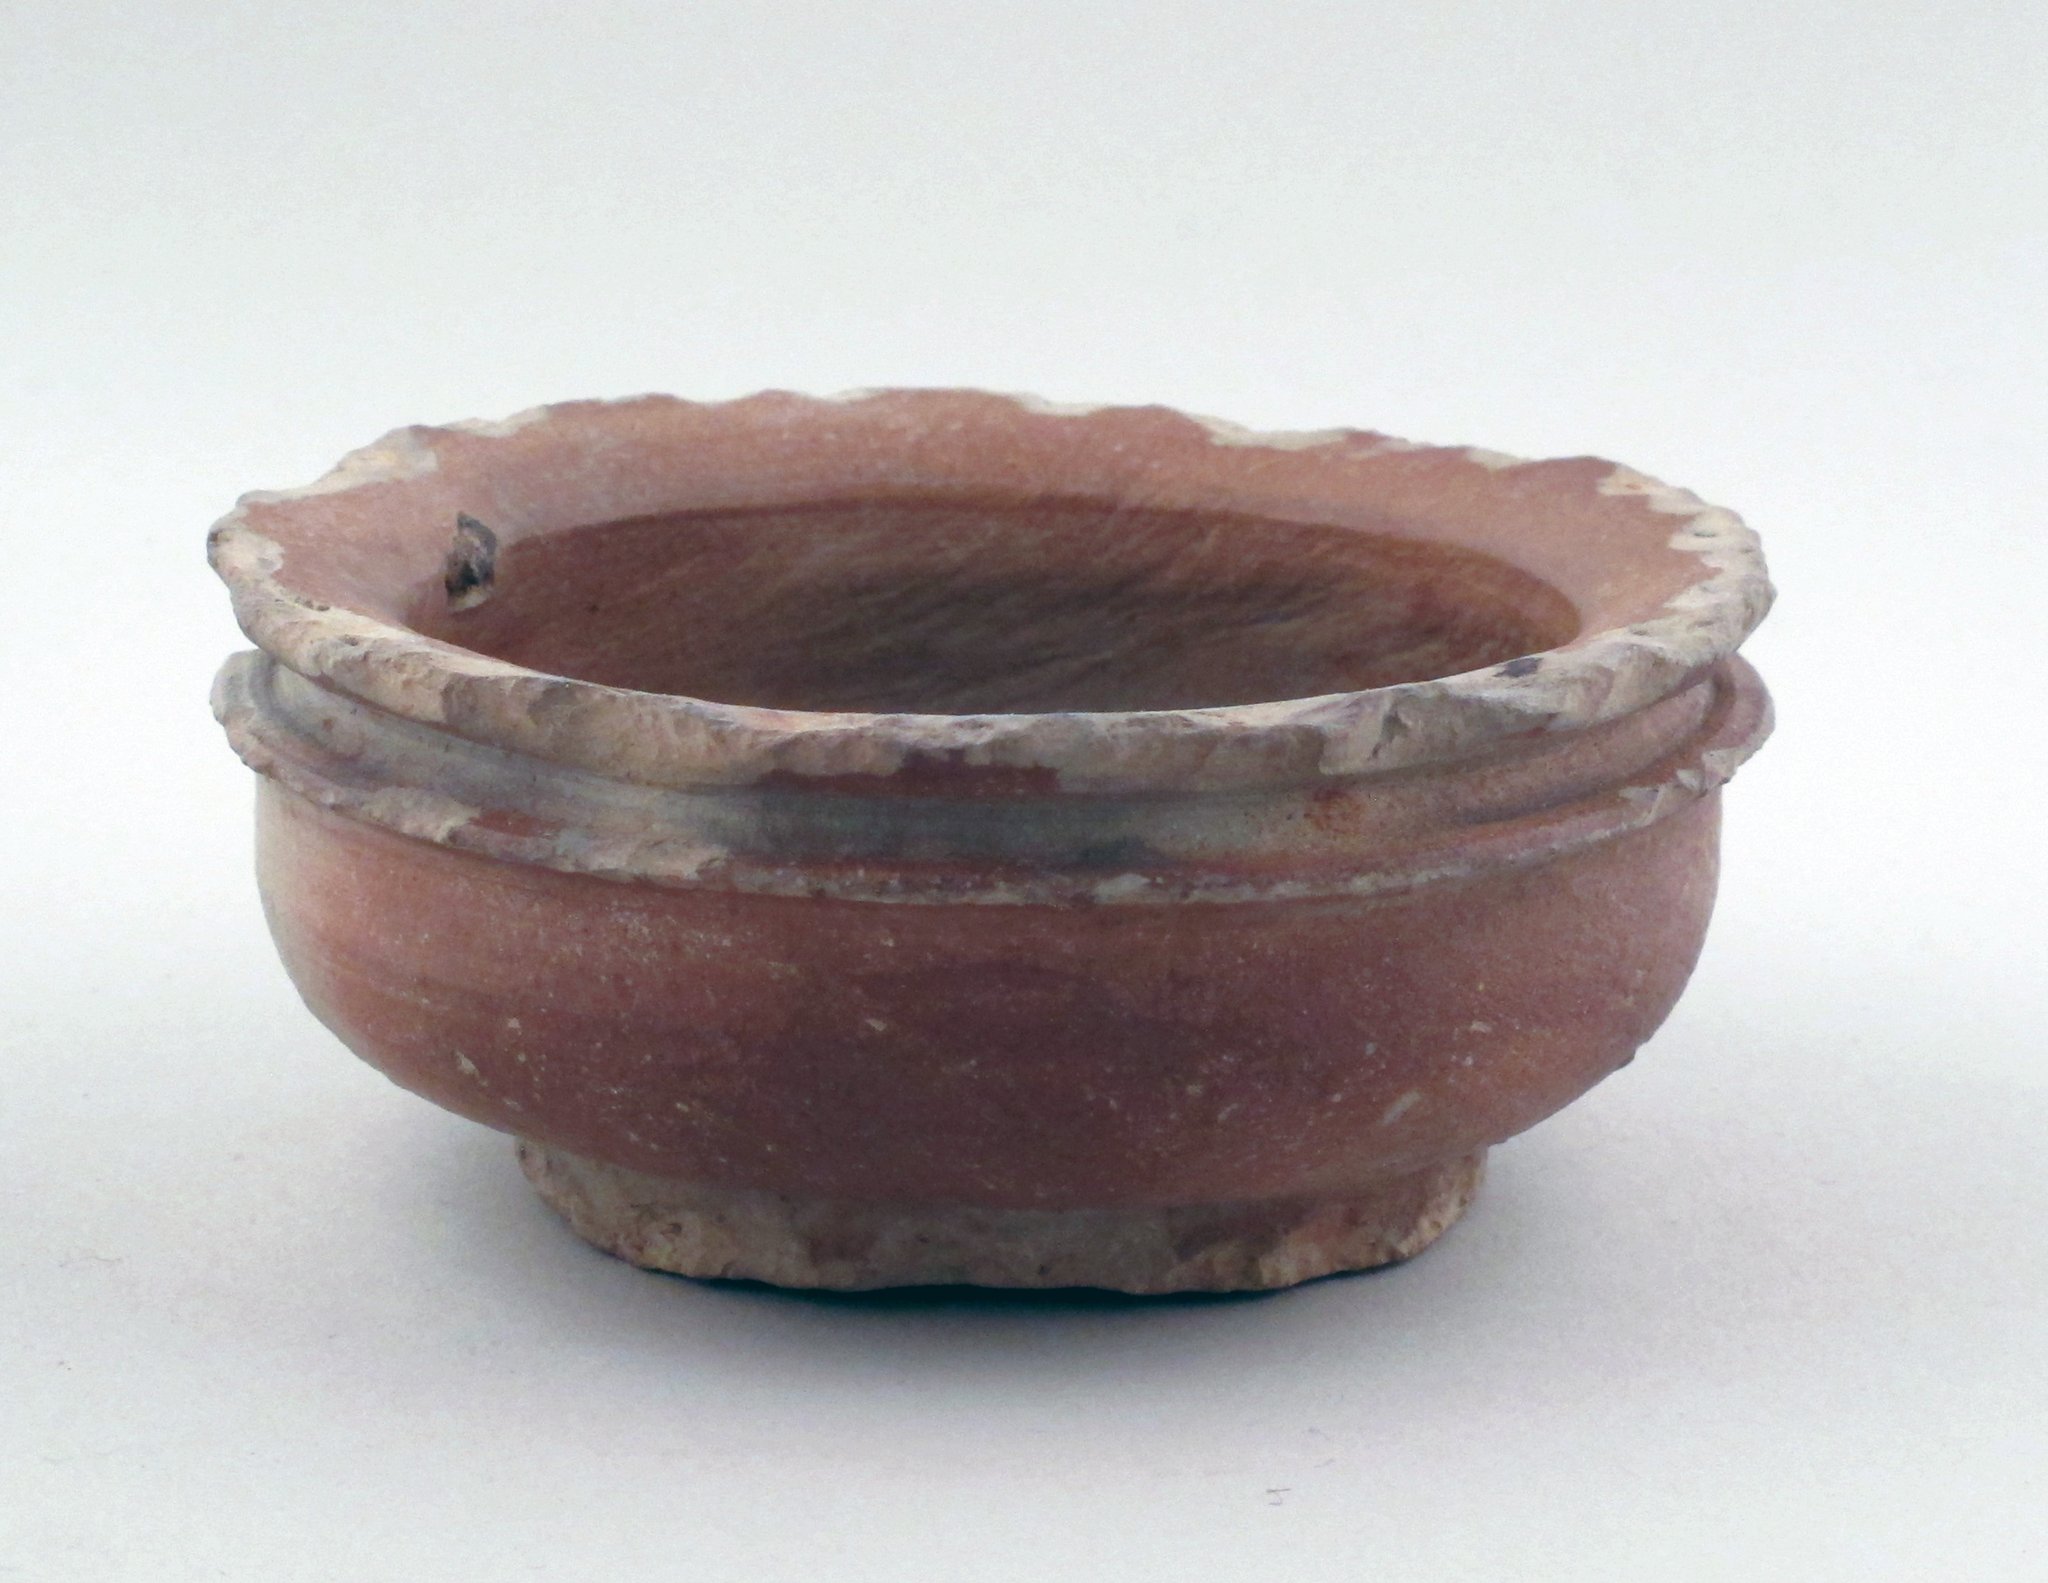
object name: bowl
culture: roman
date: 670 BCE-330 CE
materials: terracotta